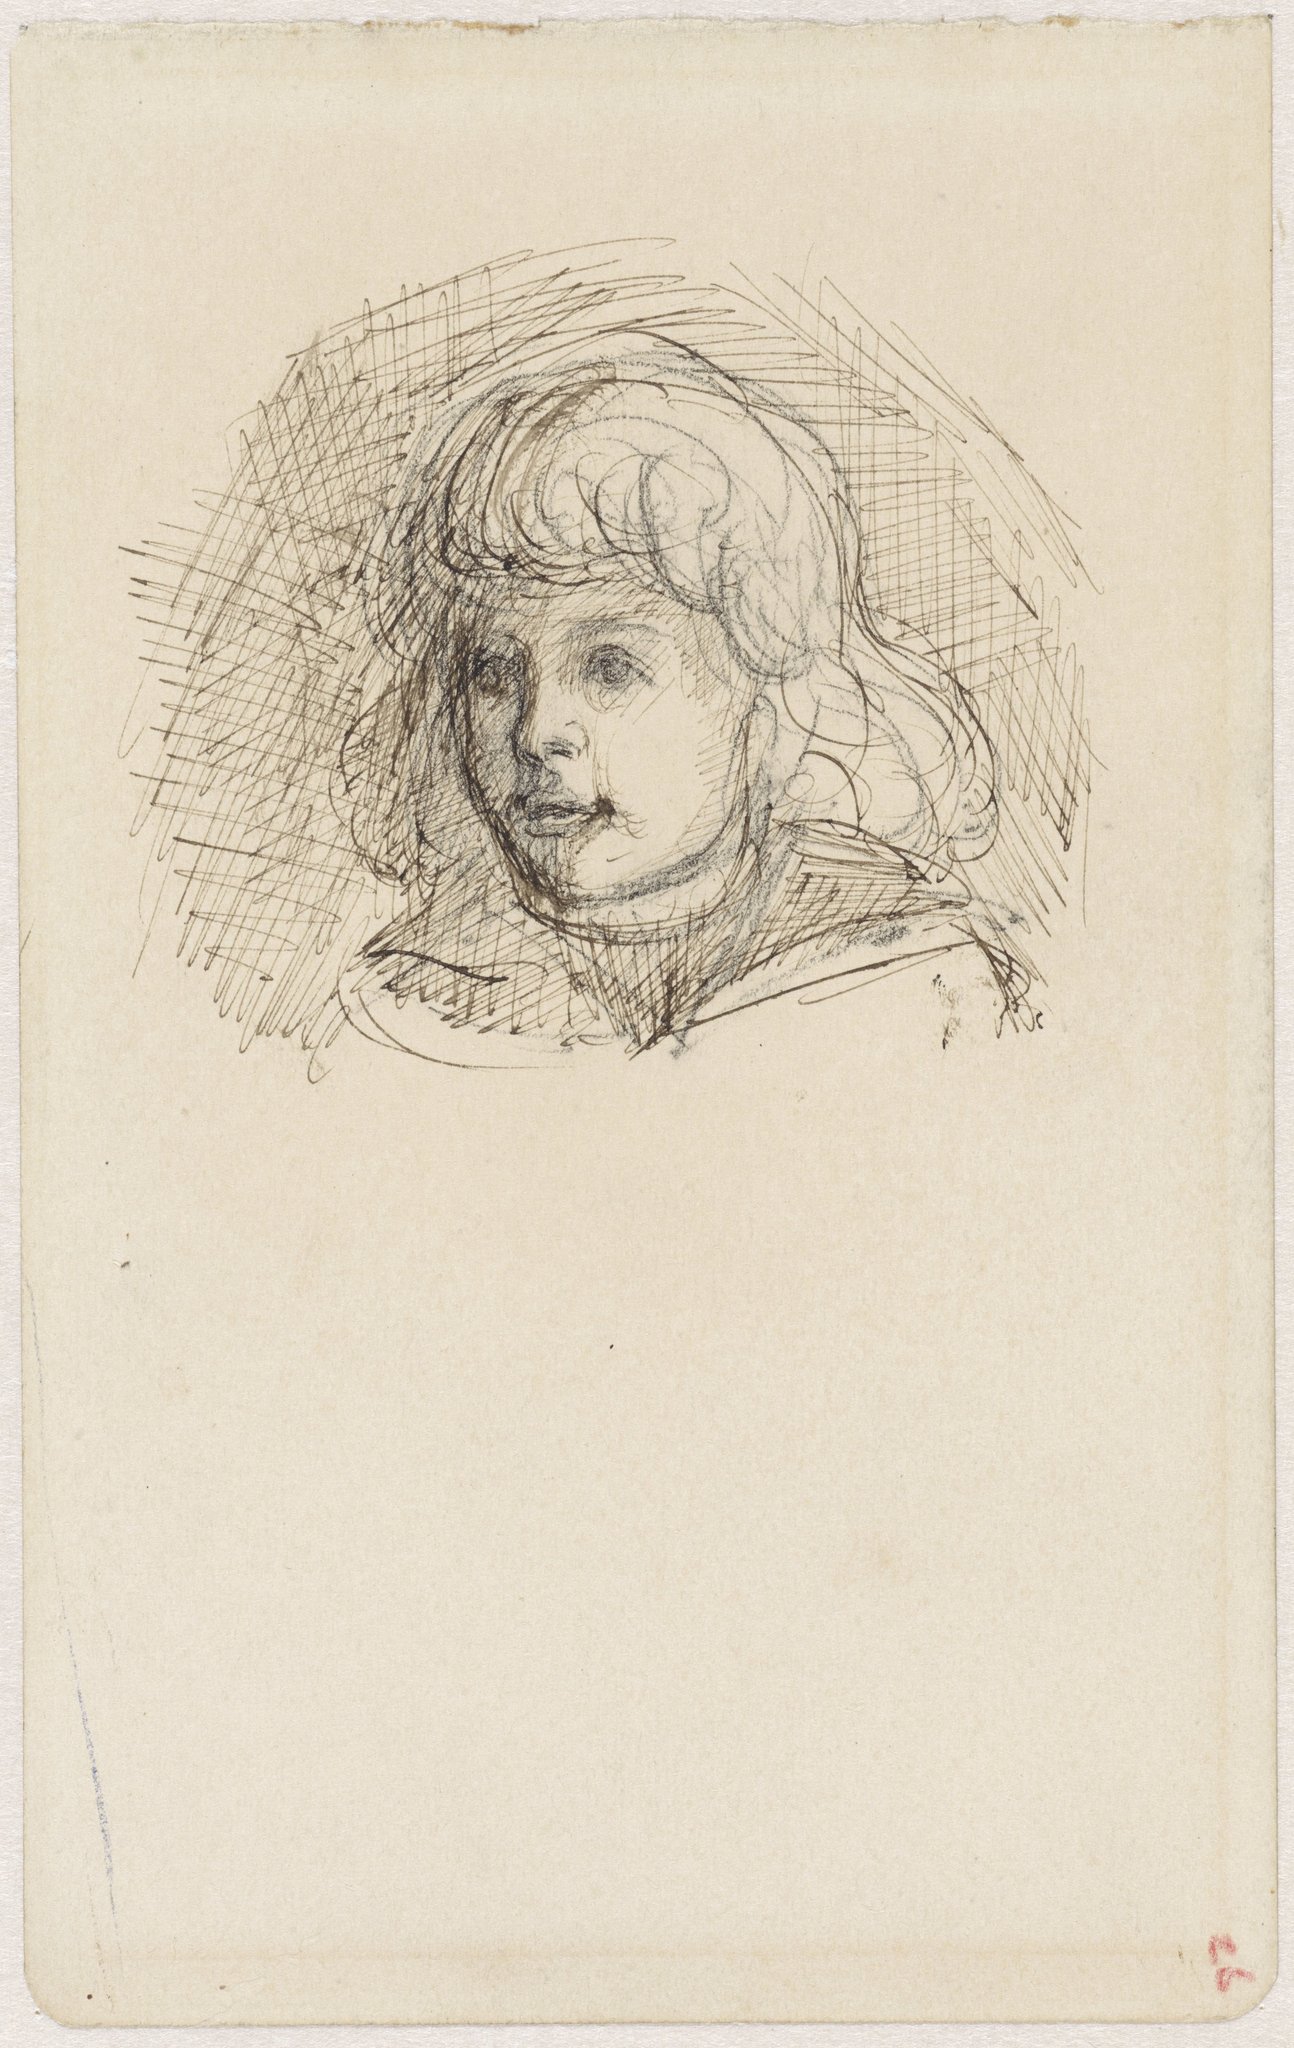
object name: drawing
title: Meisjeskopje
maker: jozef israëls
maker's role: draughtsman, painter, print maker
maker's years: 1824-1911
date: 1834-1911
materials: chalk, ink, paper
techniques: pen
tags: anonymous historical person portrayed alone